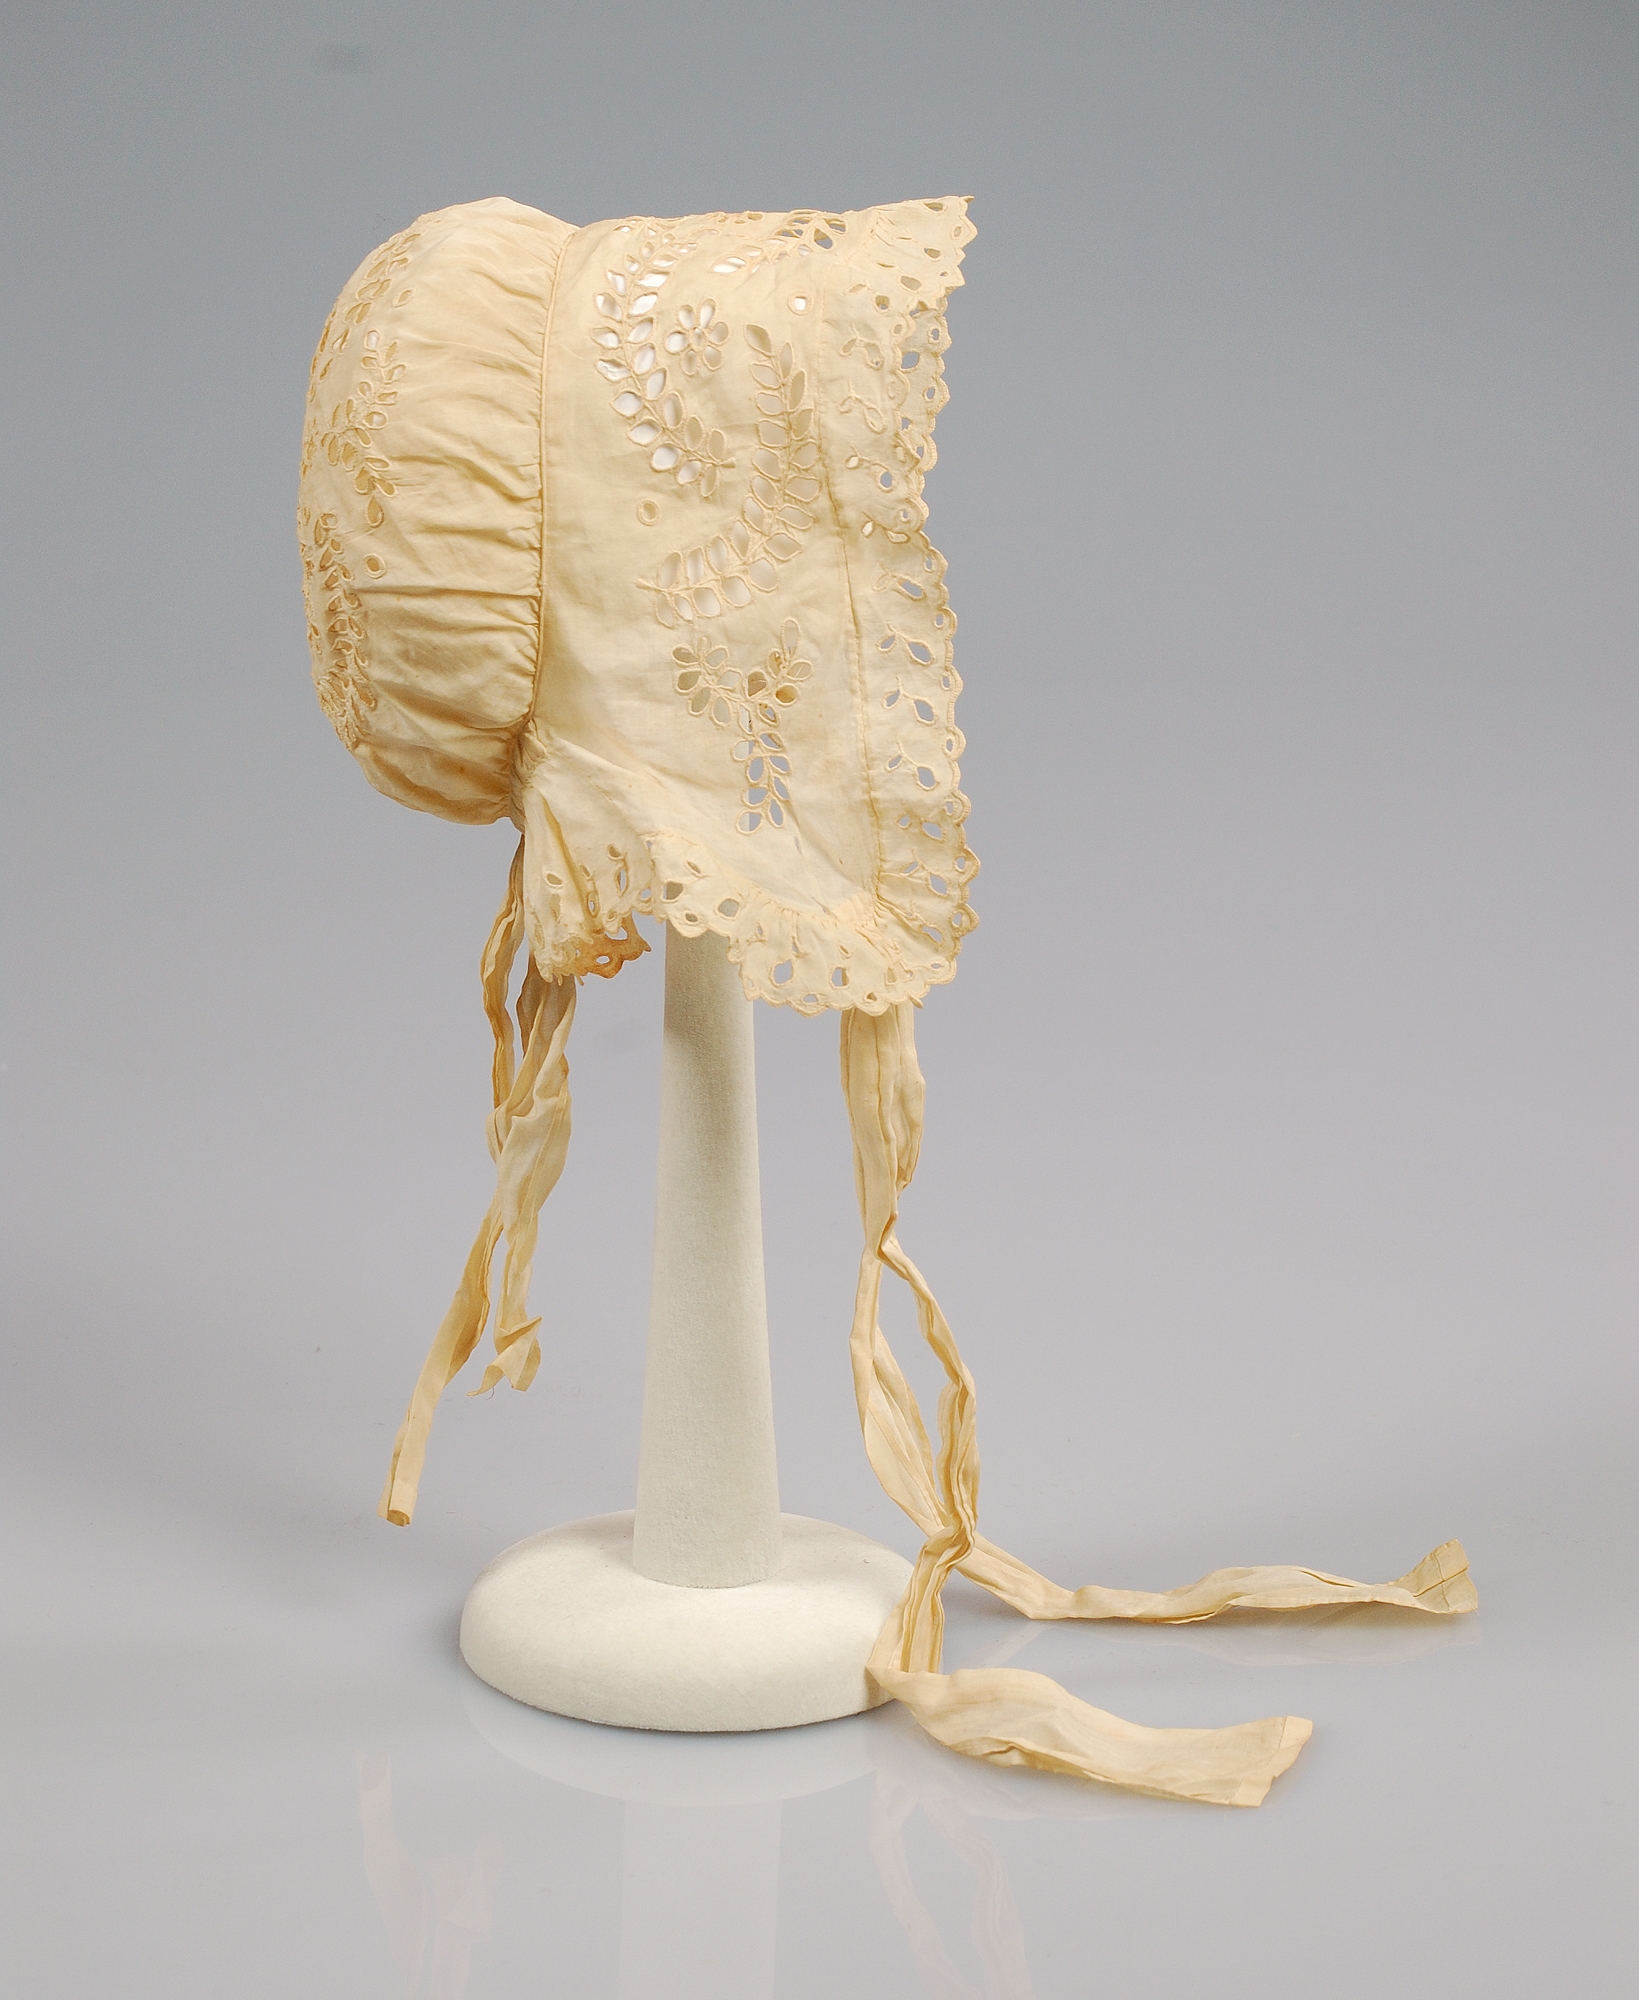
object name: sunbonnet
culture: american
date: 1890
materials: cotton